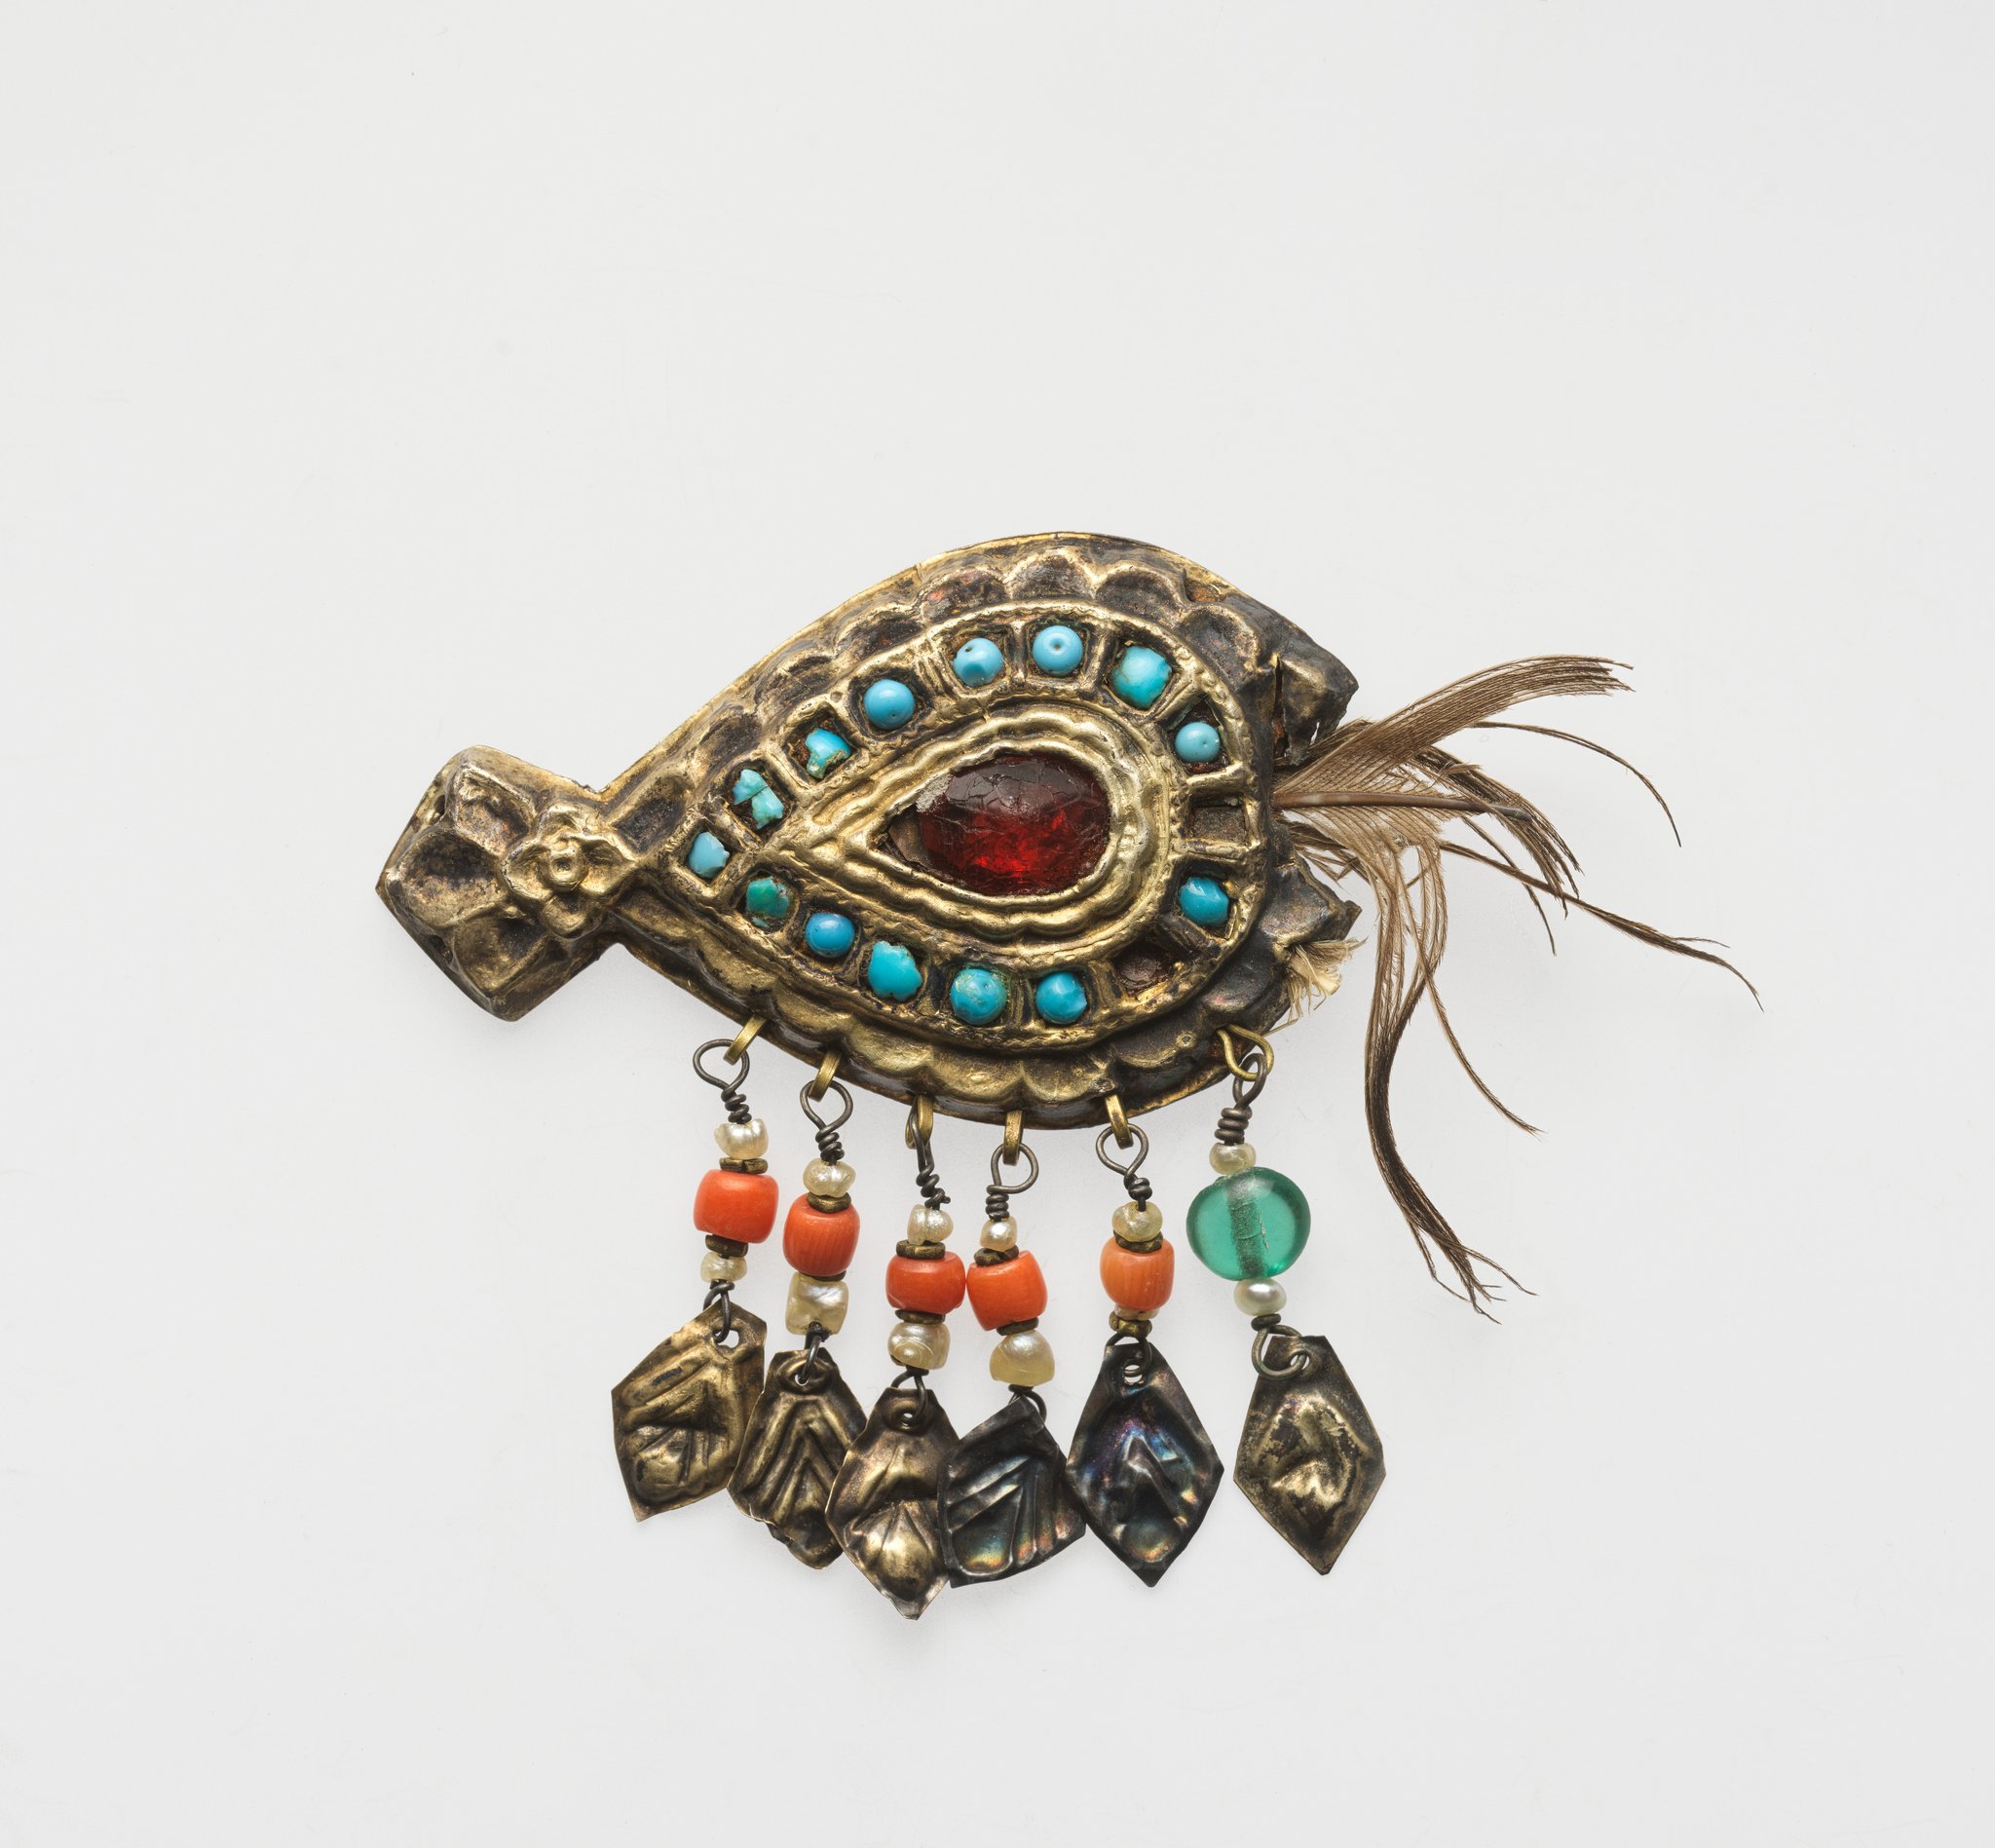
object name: ornament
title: Ornament, One of a Pair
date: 1801-1850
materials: gemstone, feather, gold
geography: uzbekistan